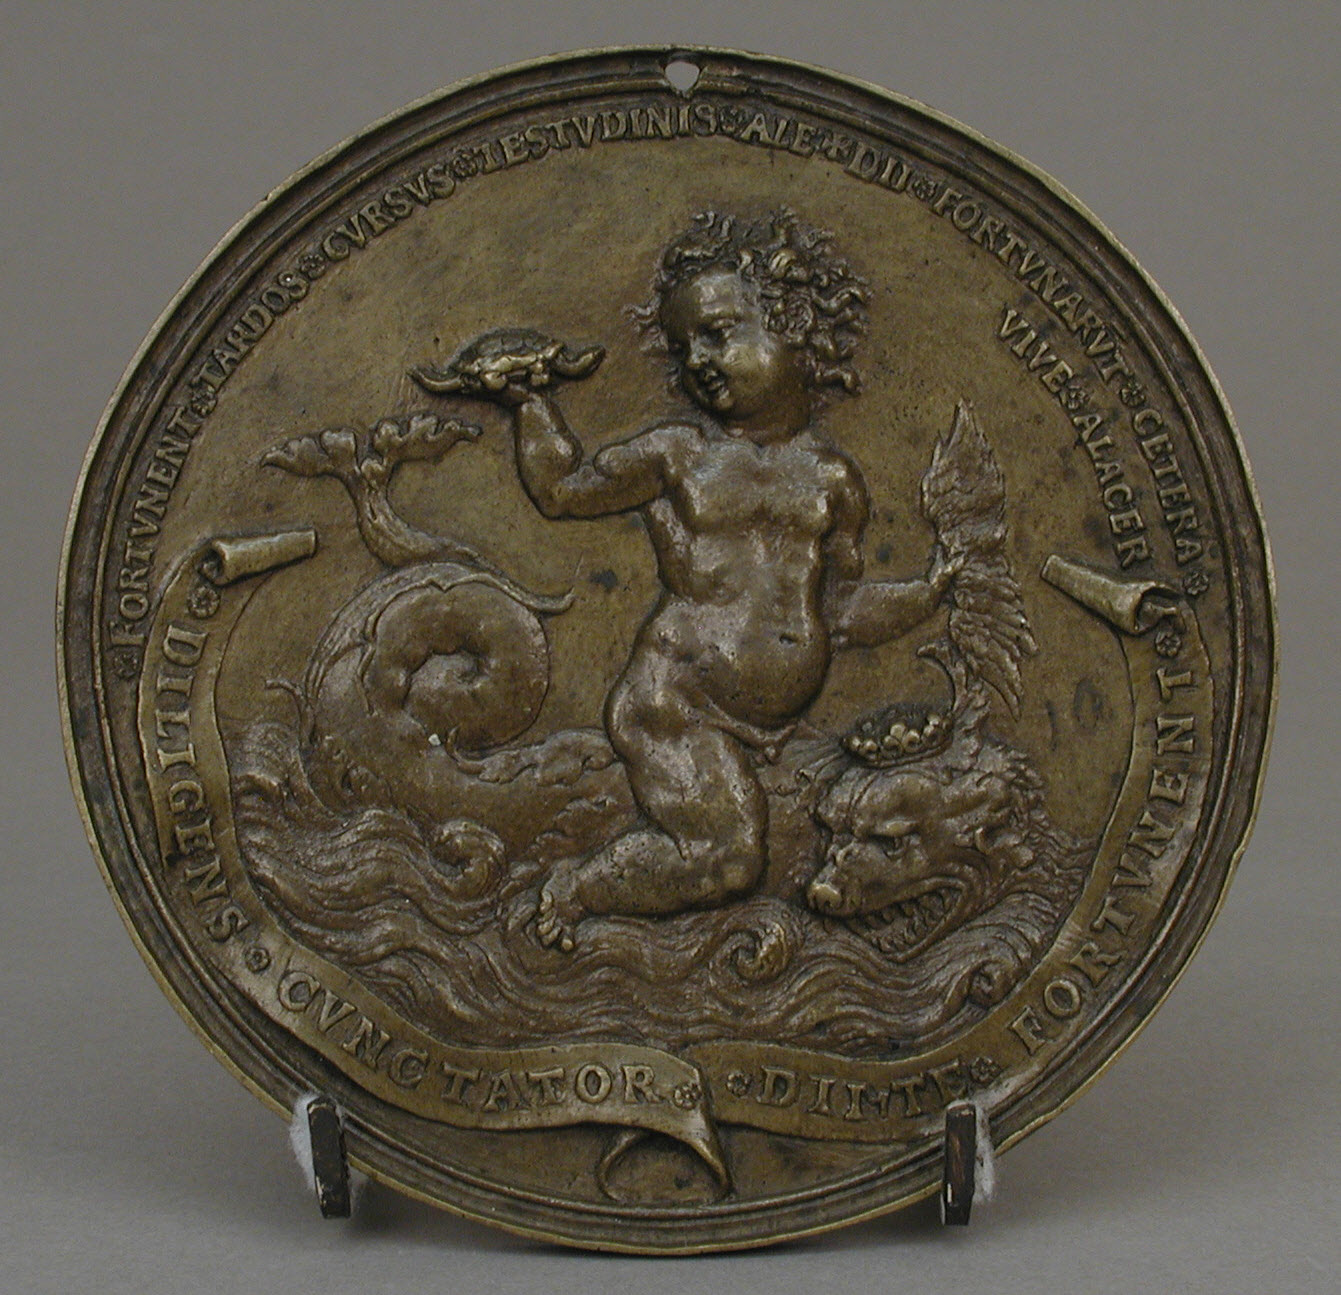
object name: medal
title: Commemoration of the Visit of the Dauphin Francis, Son of Francis I, to the City of Lyon in 1533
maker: jacques gauvain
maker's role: artist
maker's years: 1501-1547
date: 1533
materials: bronze, patina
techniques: casting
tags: boys,dolphins,turtles